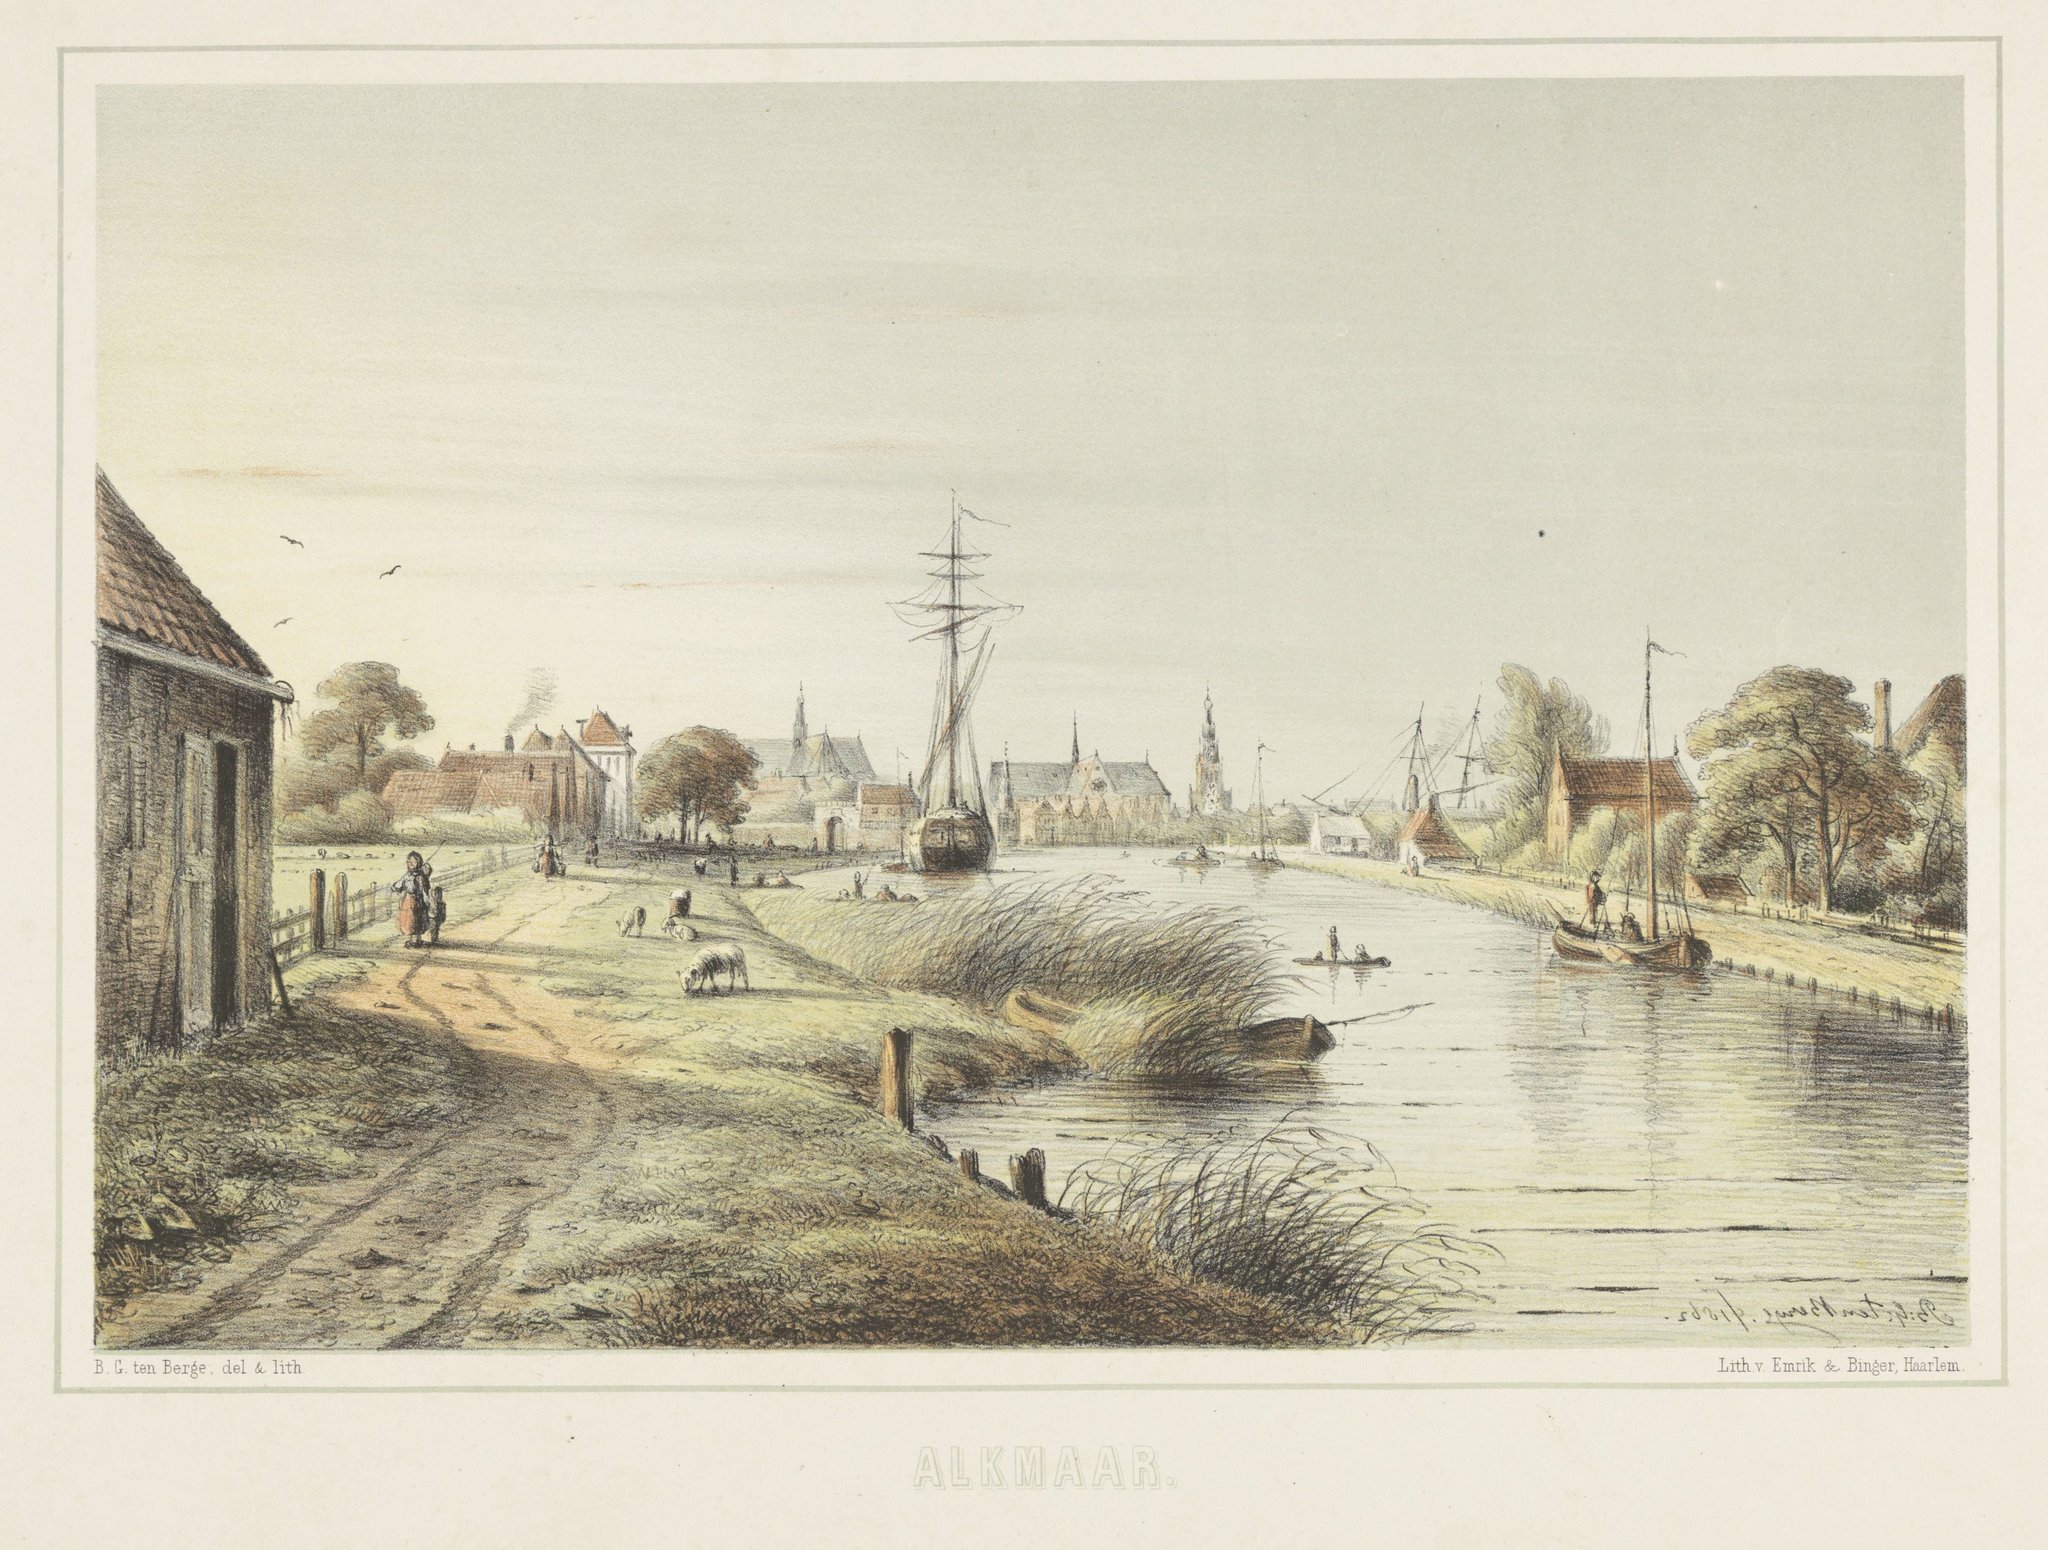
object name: print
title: Gezicht op Alkmaar vanaf het Zeglis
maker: bernardus gerardus ten berge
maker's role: draughtsman, print maker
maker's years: 1835-1875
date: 1845-1875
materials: paper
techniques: lithograph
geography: haarlem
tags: city-view in general; 'veduta', river, ships (in general), roman catholic church, sheep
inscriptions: collector's mark: Lugt 2228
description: Op de oever aan de linkerkant grazen schapen en wandelen figuren. Op het water liggen verschillende schepen. In de verte de Sint-Laurenskerk en de St. Josephkerk.